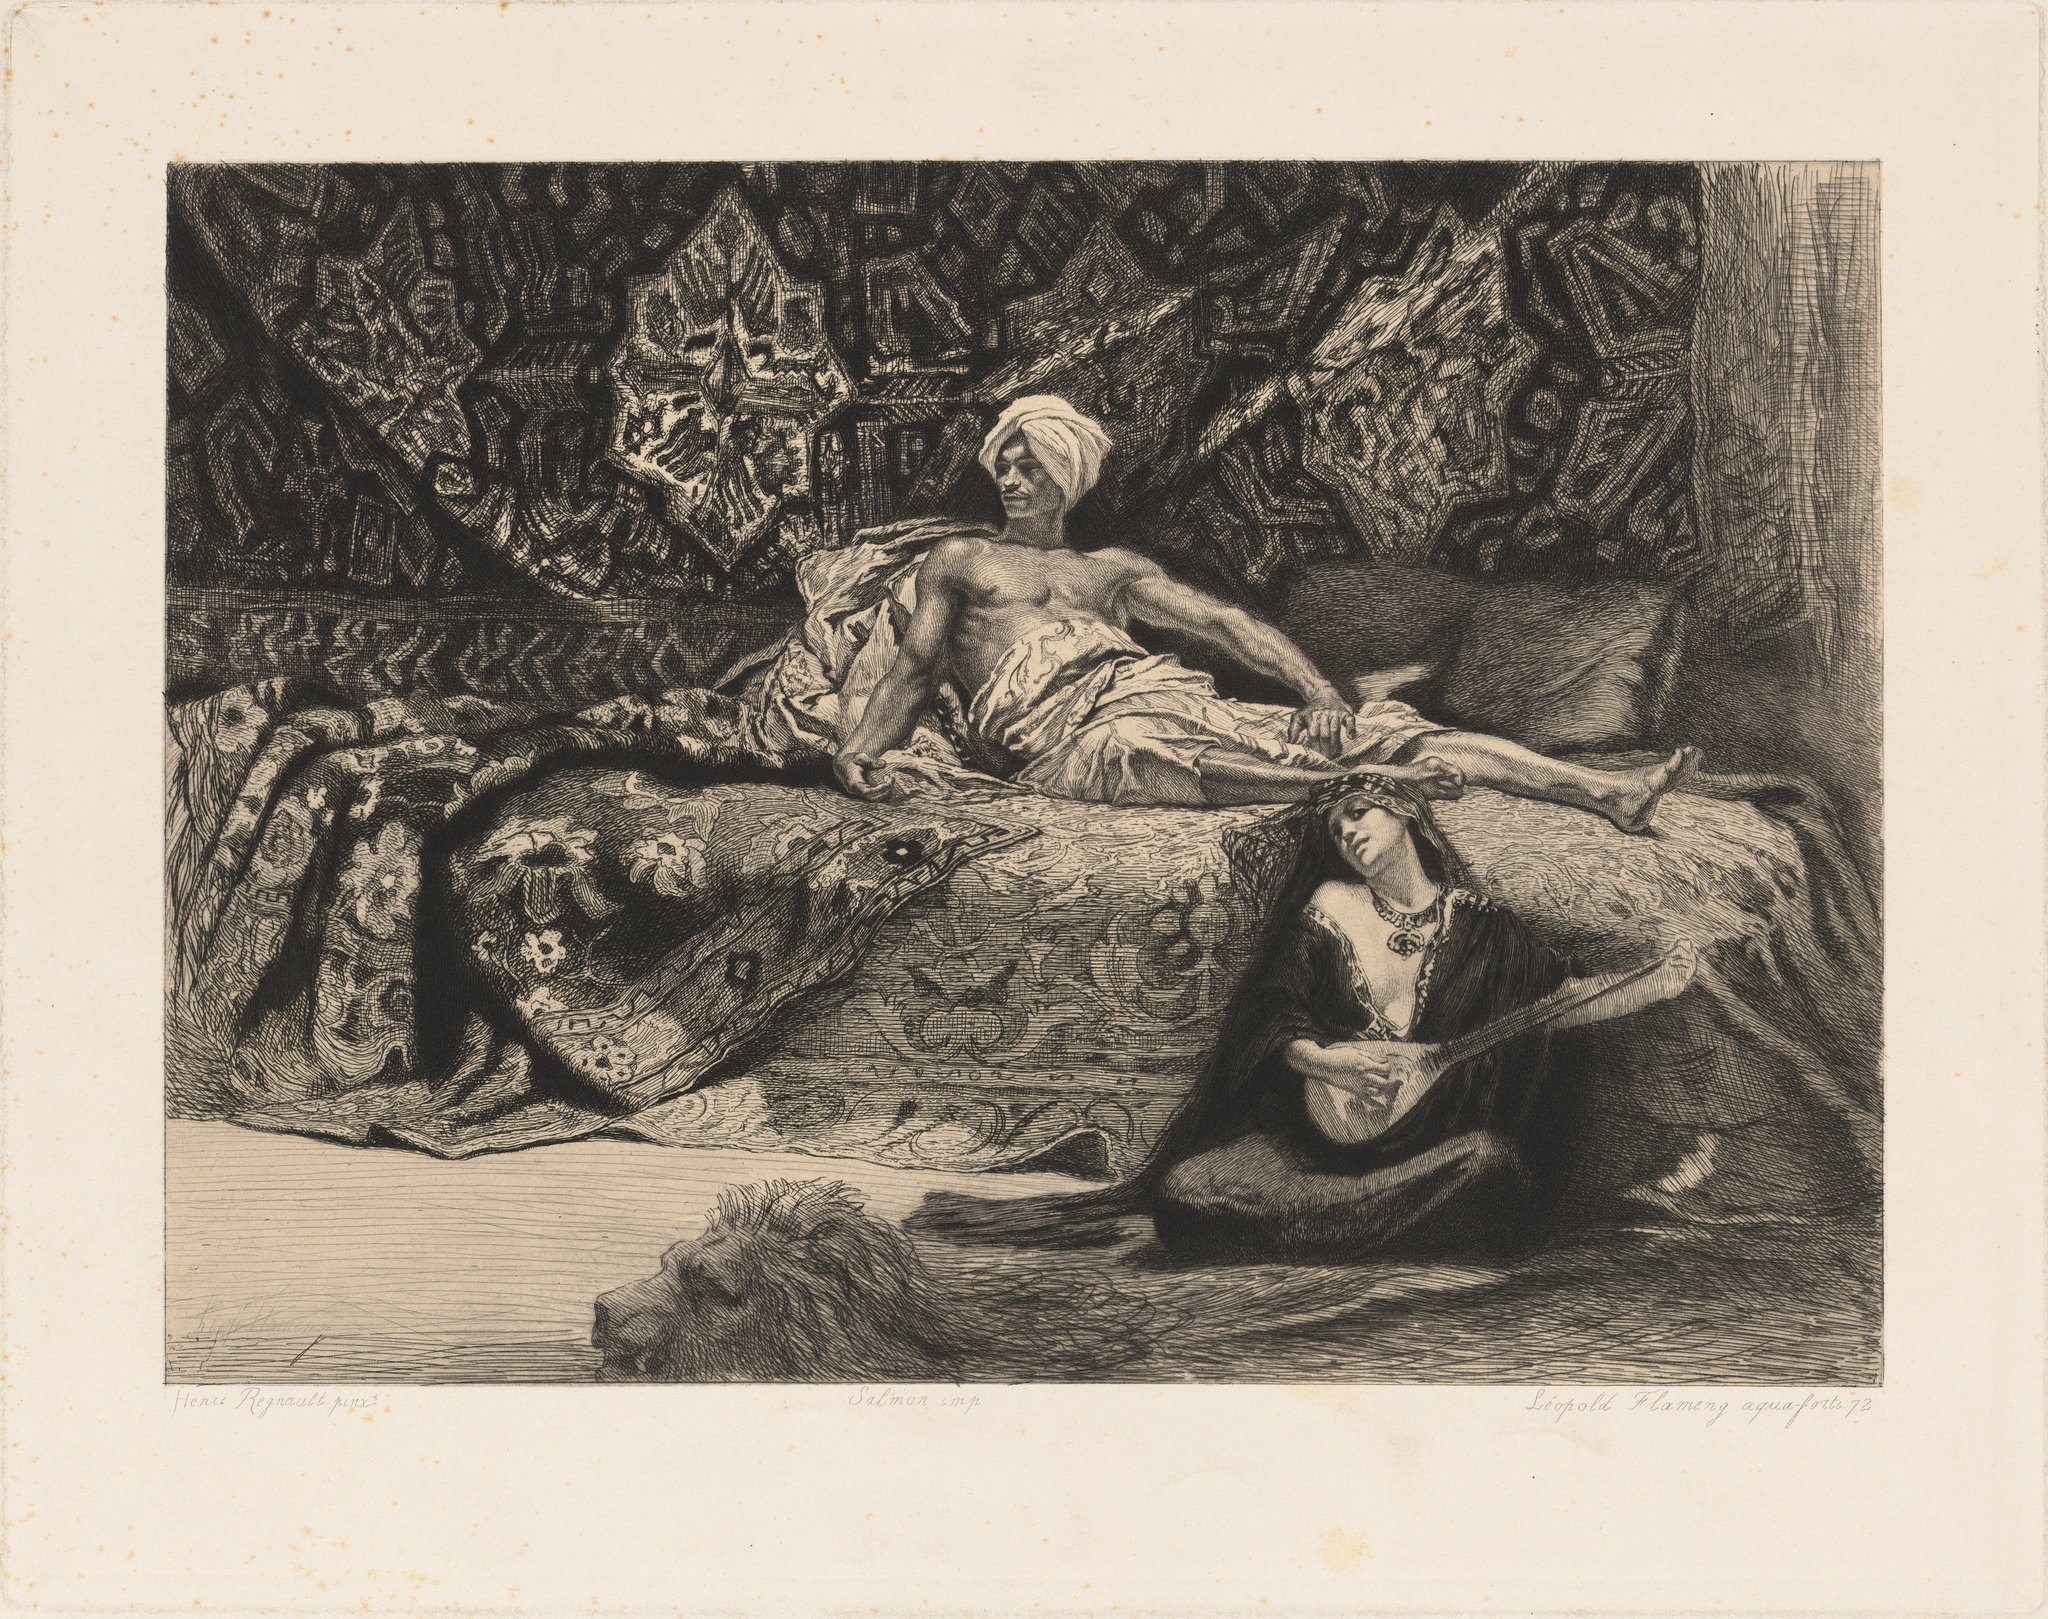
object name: print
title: Hassan and Namouna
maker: léopold flameng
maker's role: engraver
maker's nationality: french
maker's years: 1831-1911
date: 1872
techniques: etching